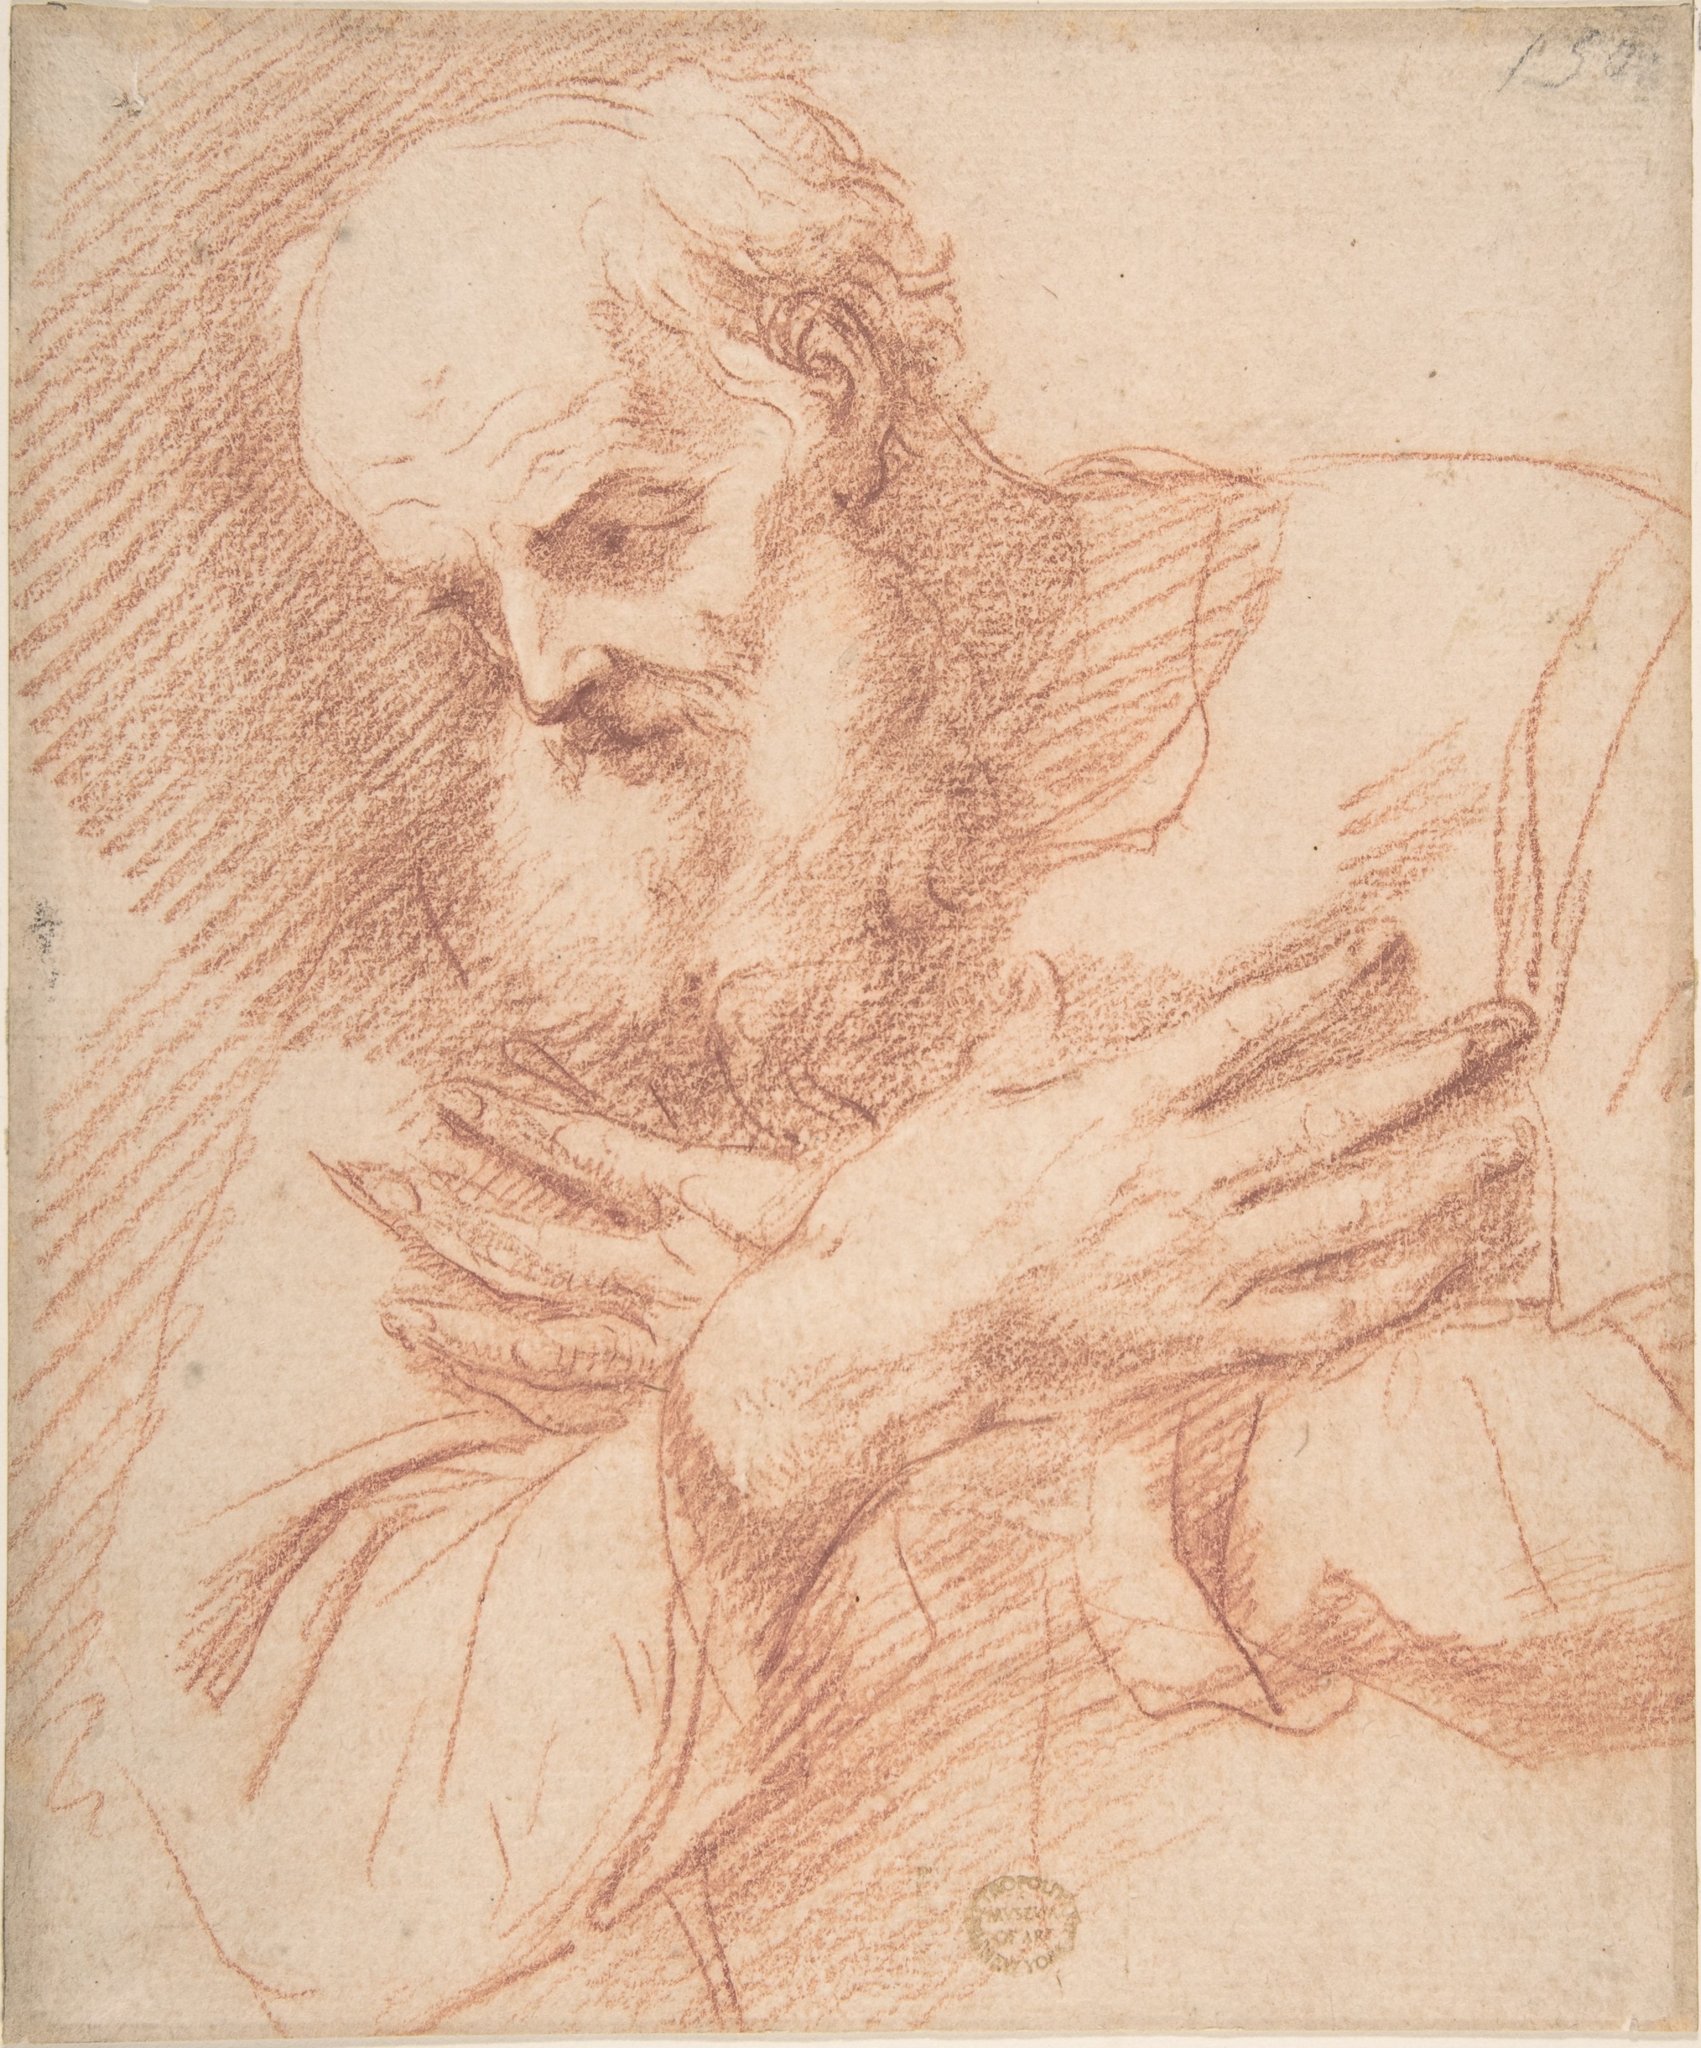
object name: drawing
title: Old Bearded Man in Three-Quarter View with Hands Crossed Over His Chest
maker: anonymous, italian, roman-bolognese, 17th century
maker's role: artist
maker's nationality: italian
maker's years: 1600-1700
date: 1601-1700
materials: chalk, paper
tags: men